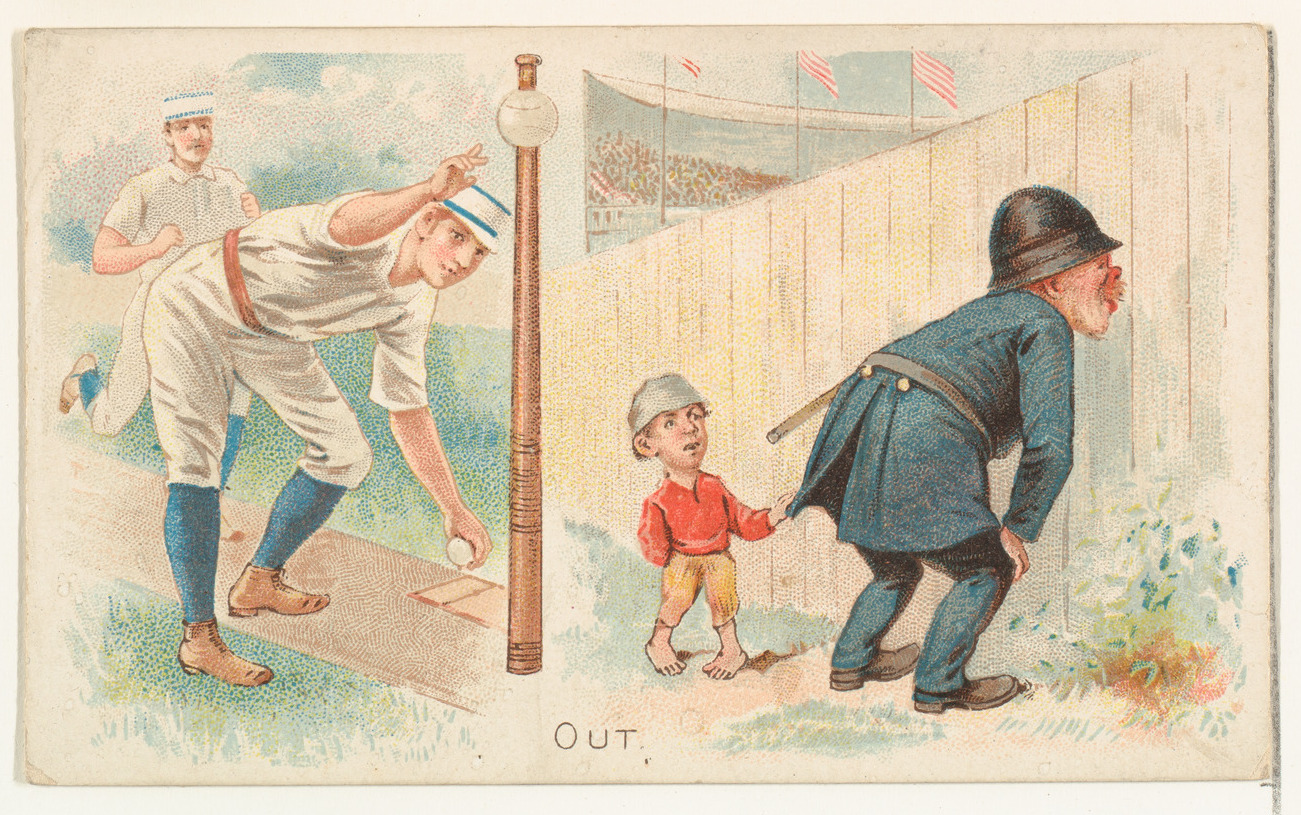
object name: print, baseball card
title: Out, from the Talk of the Diamond set (N135) issued by Duke Sons & Co., a branch of the American Tobacco Company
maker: w. duke, sons & co.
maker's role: publisher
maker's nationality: american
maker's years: 1870-1920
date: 1888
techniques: color lithograph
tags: boys,men,baseball,athletes